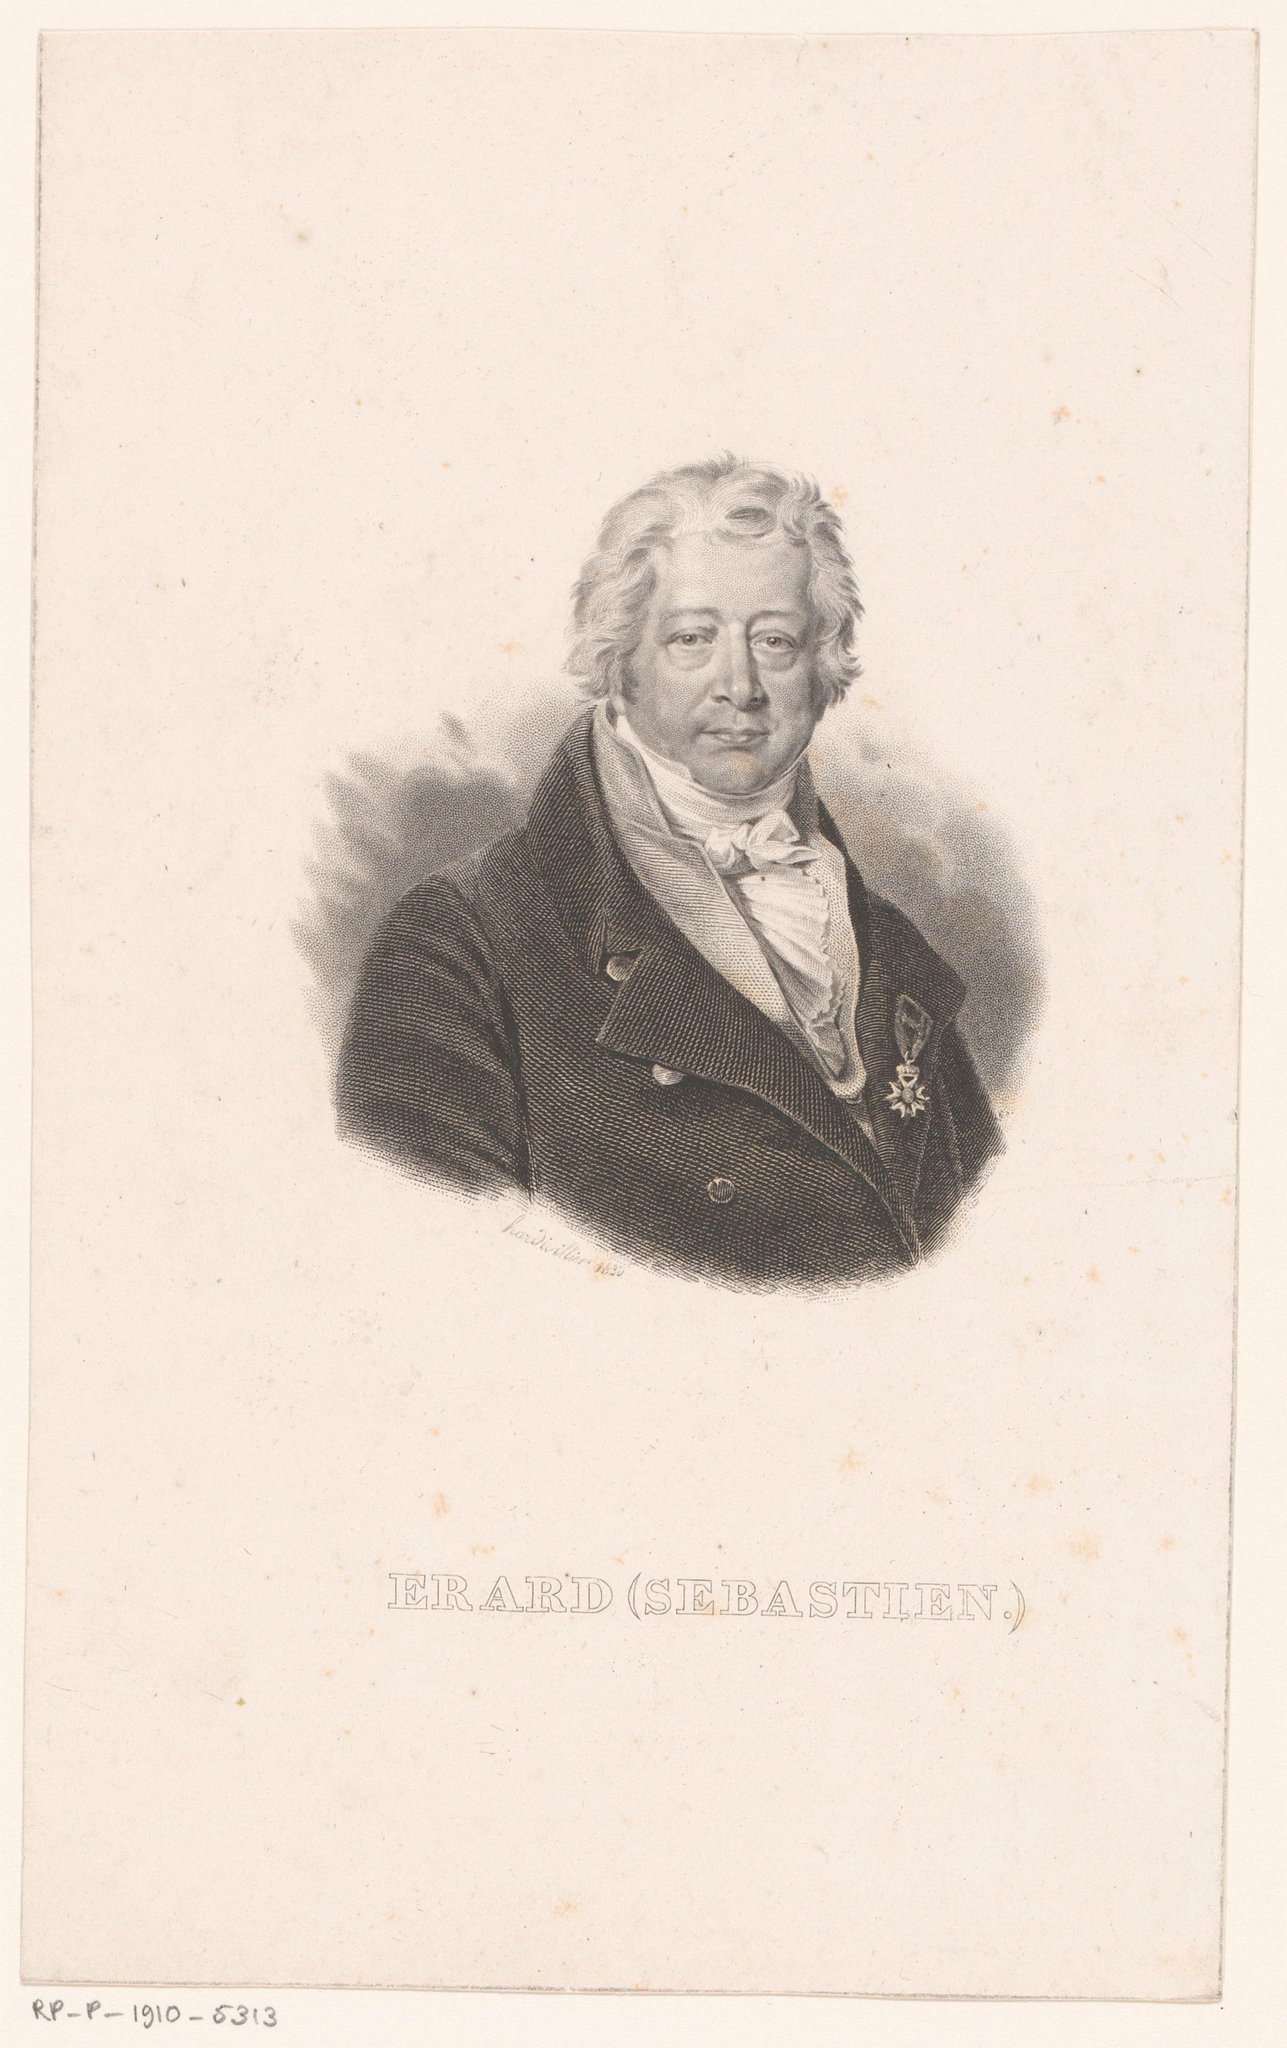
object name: print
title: Portret van Sébastien Erard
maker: charles achille d hardiviller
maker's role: print maker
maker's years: 1795-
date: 1835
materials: paper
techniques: etching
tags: paris, historical persons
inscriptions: collector's mark: Lugt 2228